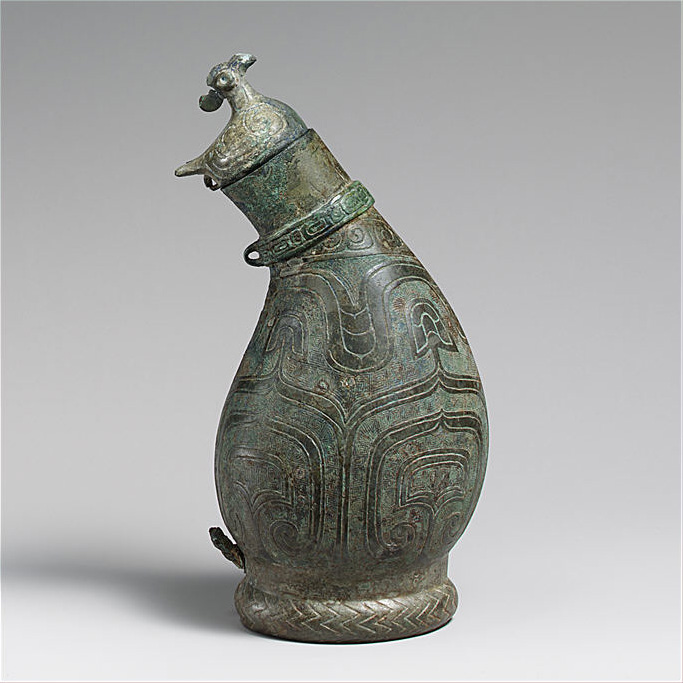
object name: wine container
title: Wine container in the shape of a leather pouch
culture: chinese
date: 800-701 BCE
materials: bronze